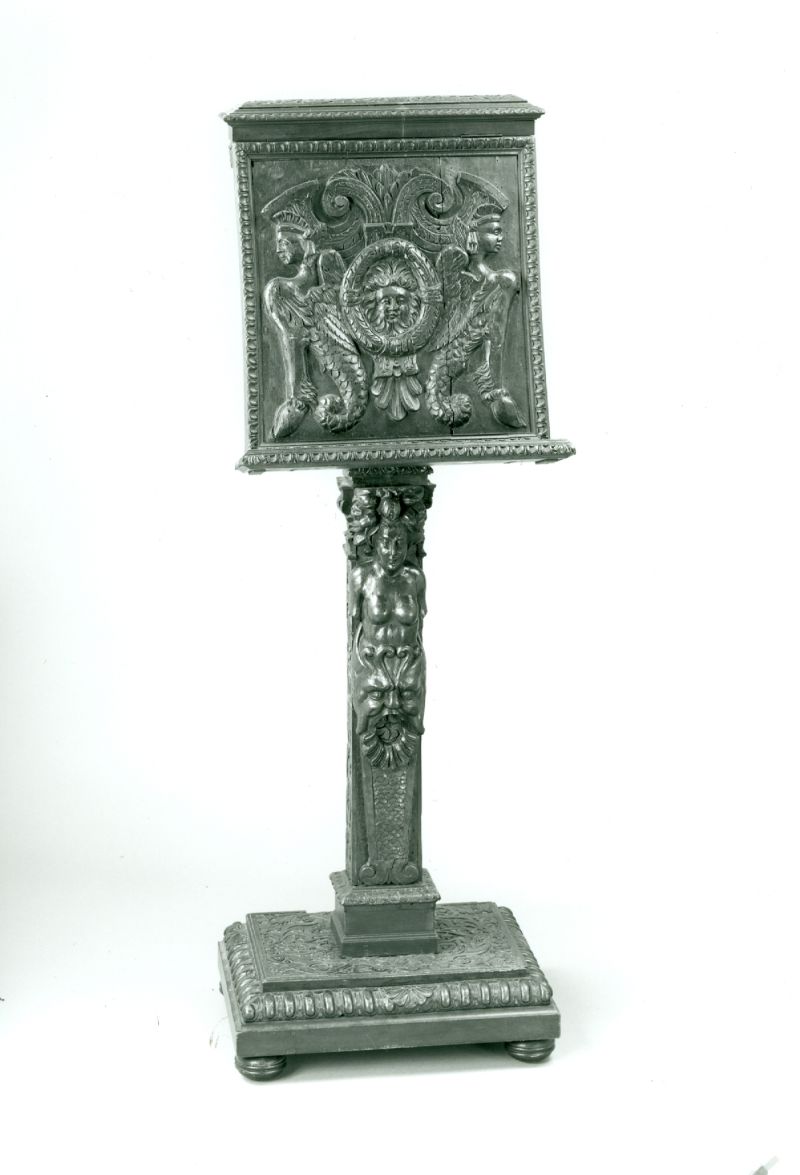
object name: lectern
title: Lectern (with revised old parts)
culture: french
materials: iron, wood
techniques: carving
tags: caryatids,sphinx